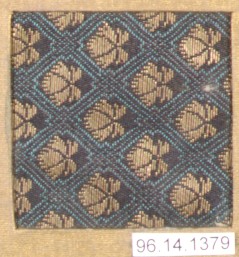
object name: piece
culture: japanese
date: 1701-1900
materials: silk